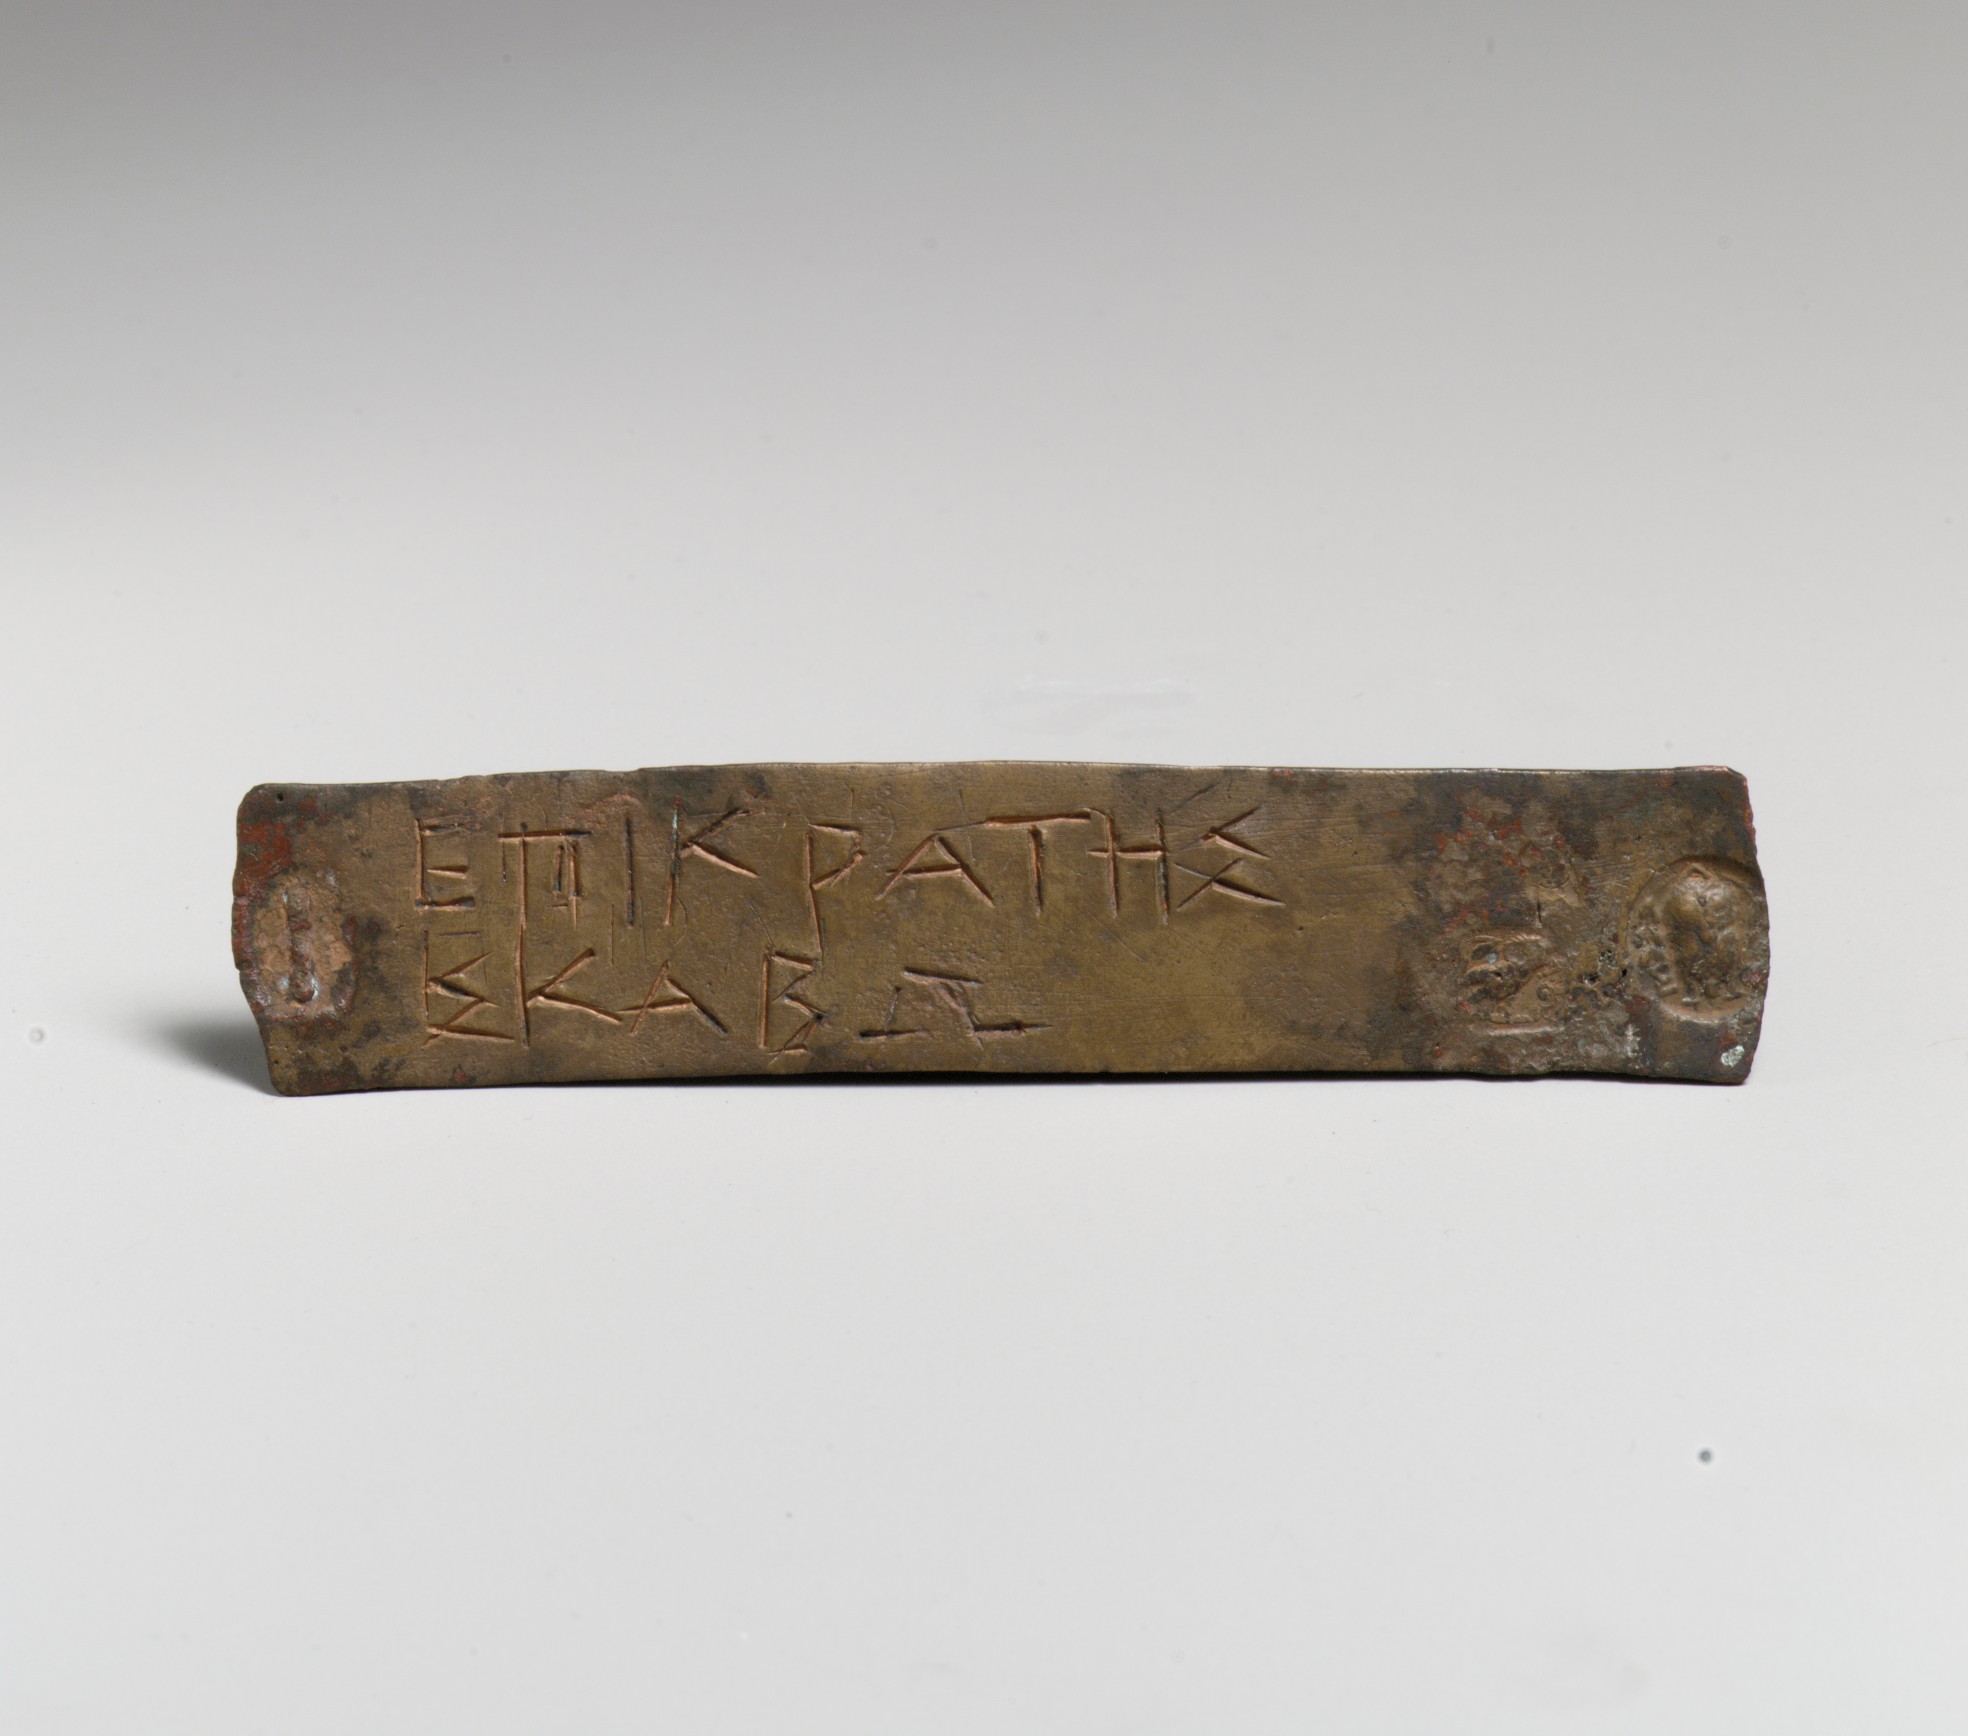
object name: dikast's ticket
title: Bronze juror's identification ticket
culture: greek, attic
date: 400-301 BCE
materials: bronze